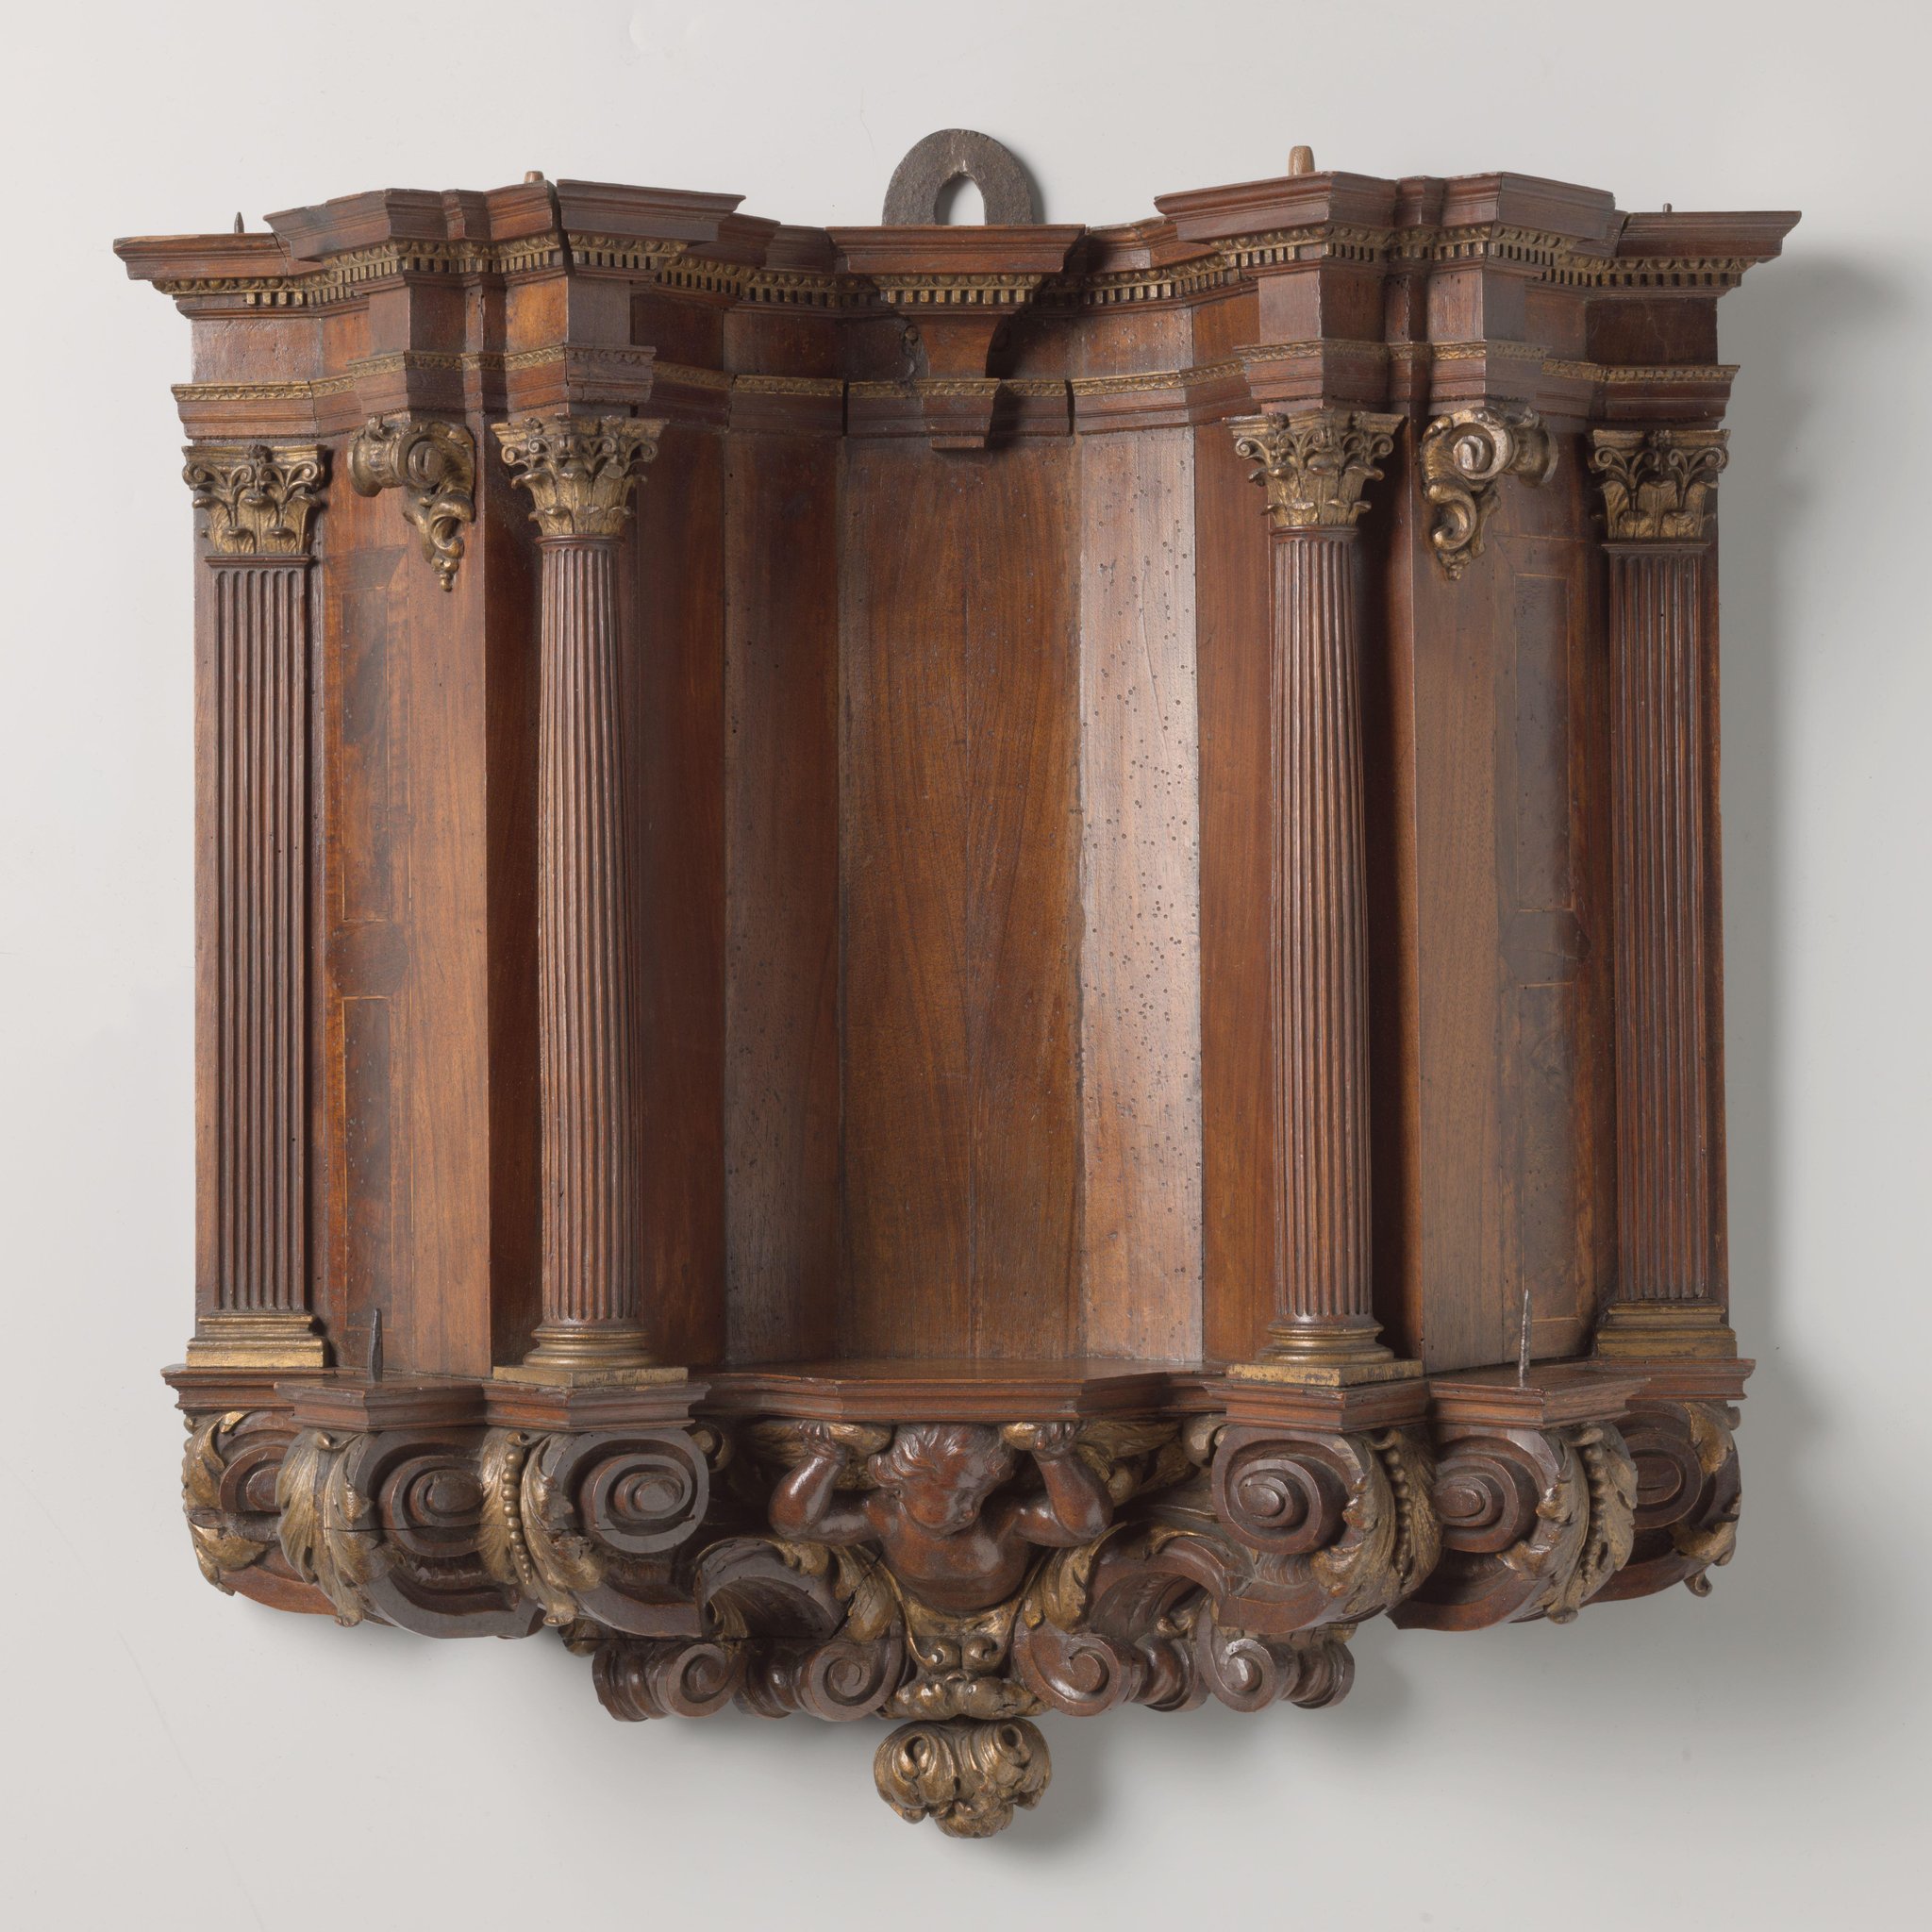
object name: sculpture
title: Console van devotie-altaar met Maria en Christuskind tussen twee engelen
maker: Anonymous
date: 1700-1750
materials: wood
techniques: gilding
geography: southern netherlands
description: Huisaltaar met Maria en Christuskind tussen twee engelen. Het Christuskind staat op een hoge sokkel. Boven Maria en het Kind zit God geflankeerd door twee engelen die een baldakijn boven Hem ophouden. Op verschillende plaatsen is het hout verguld.